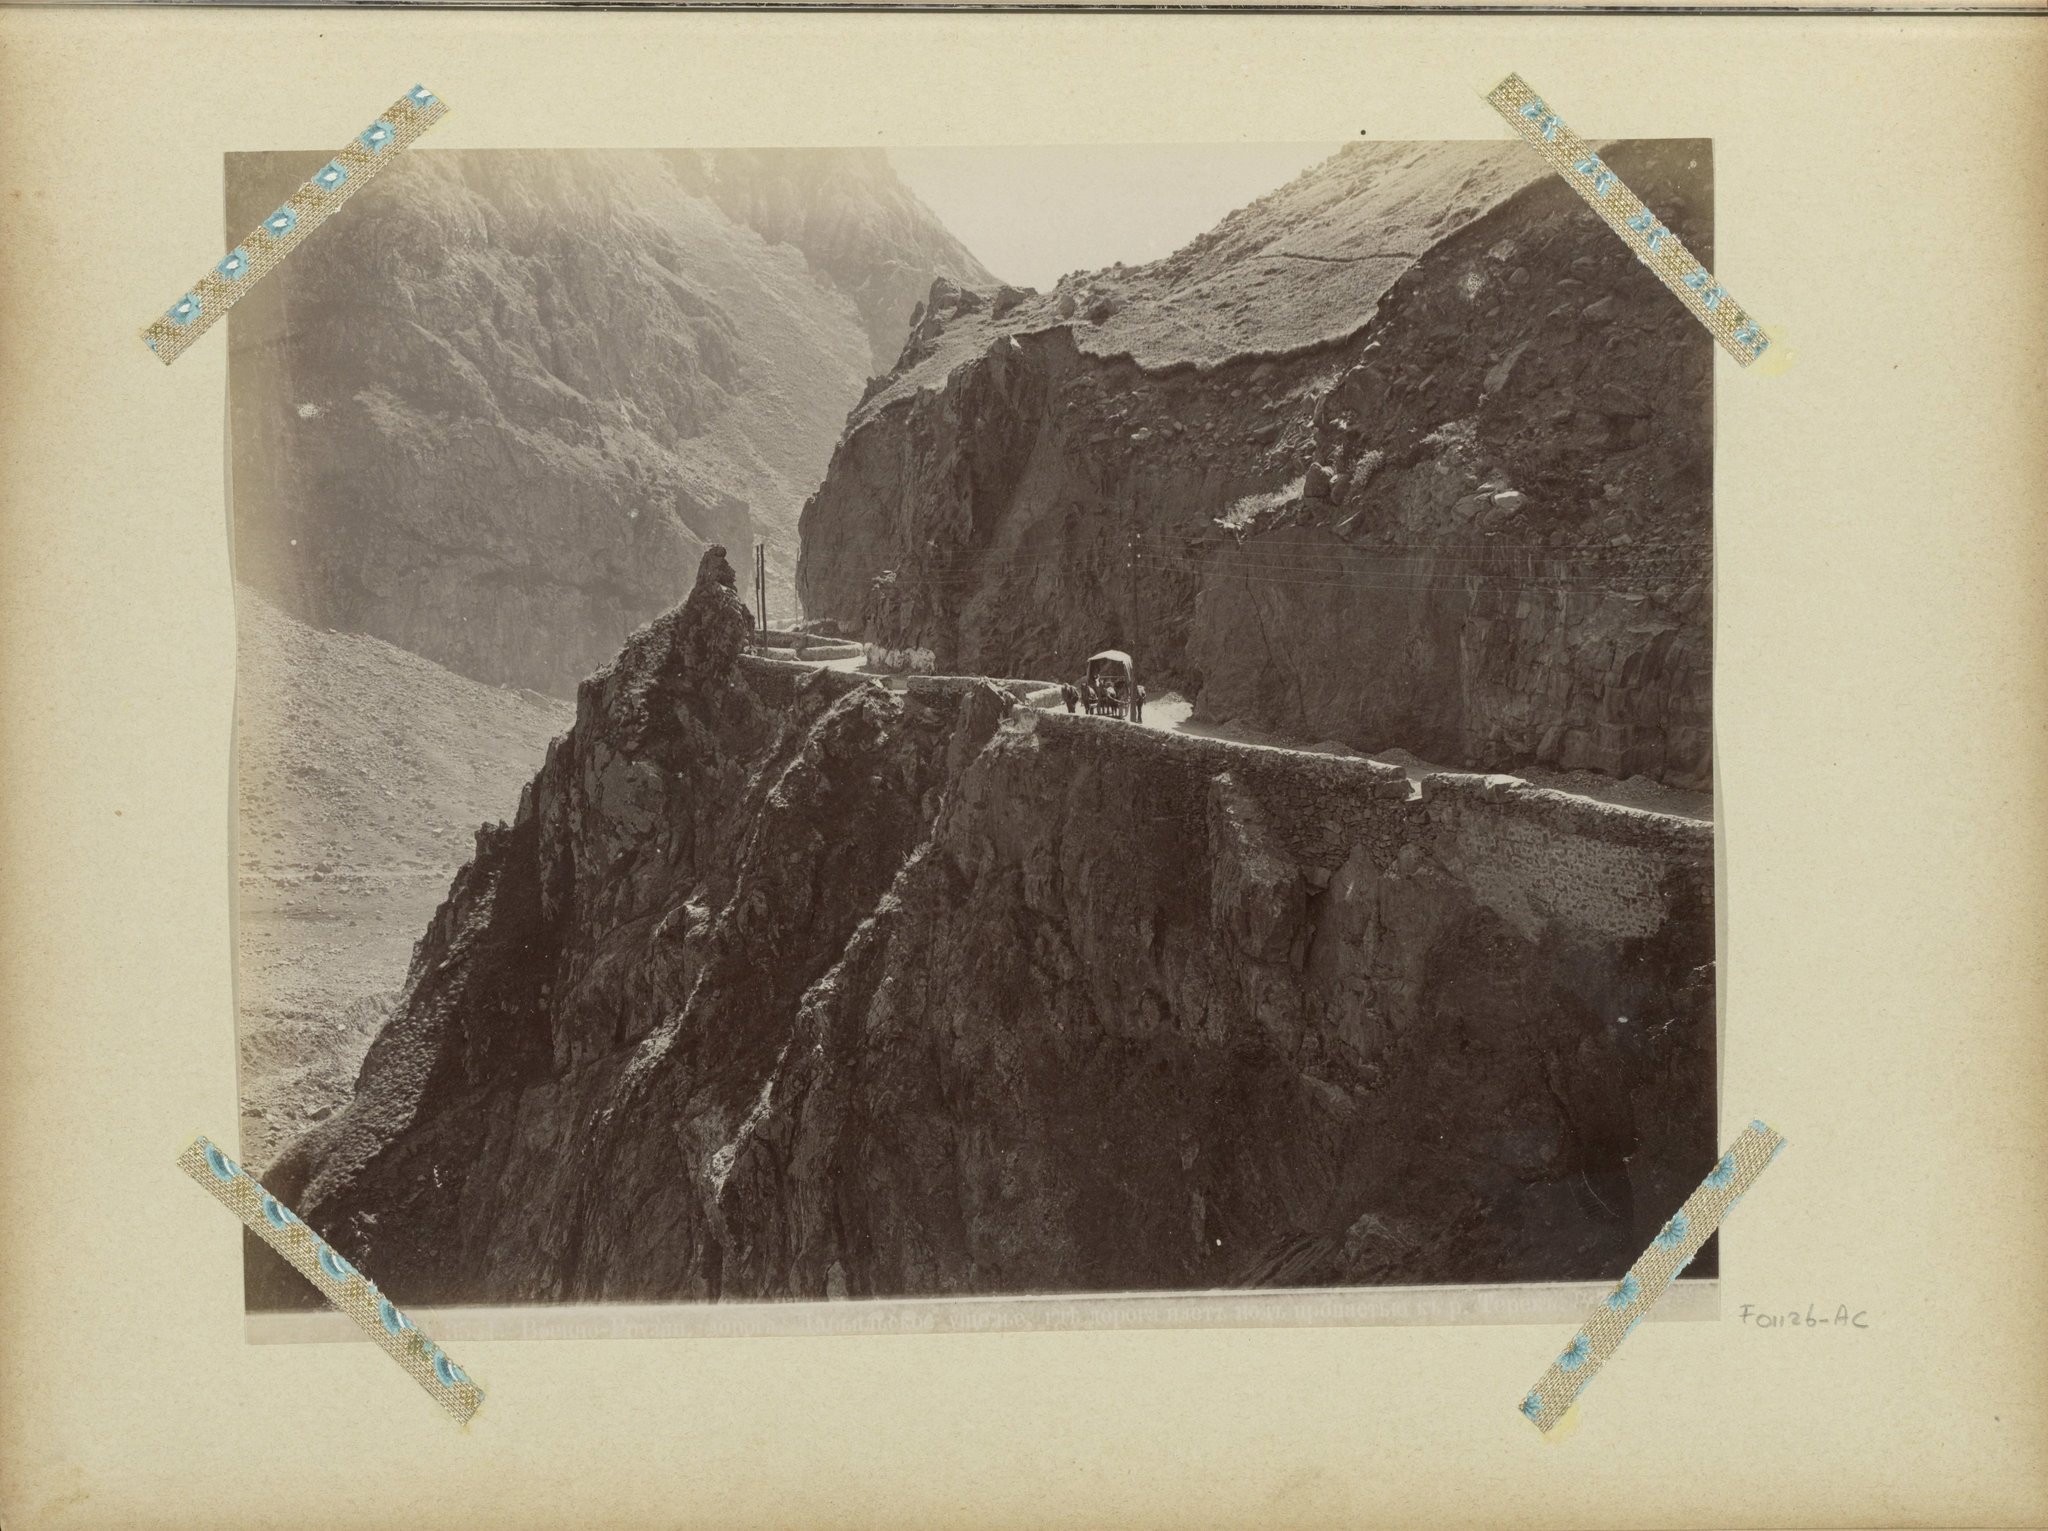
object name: photograph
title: Paardenkar op een militaire weg door de bergen van Georgië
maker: dimitri ivanovitch ermakov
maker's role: fotograaf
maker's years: 1845-1916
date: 1890-1900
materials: photographic support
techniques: albumen print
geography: georgia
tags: animal traction, animal-drawn vehicle (carriage etc.), road, path, mountains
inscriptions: number: ‘3554’, number: ‘[...]47’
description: Onderdeel van Fotoalbum met opnames van bezienswaardigheden in Georgië, Sint-Petersburg en Moskou.